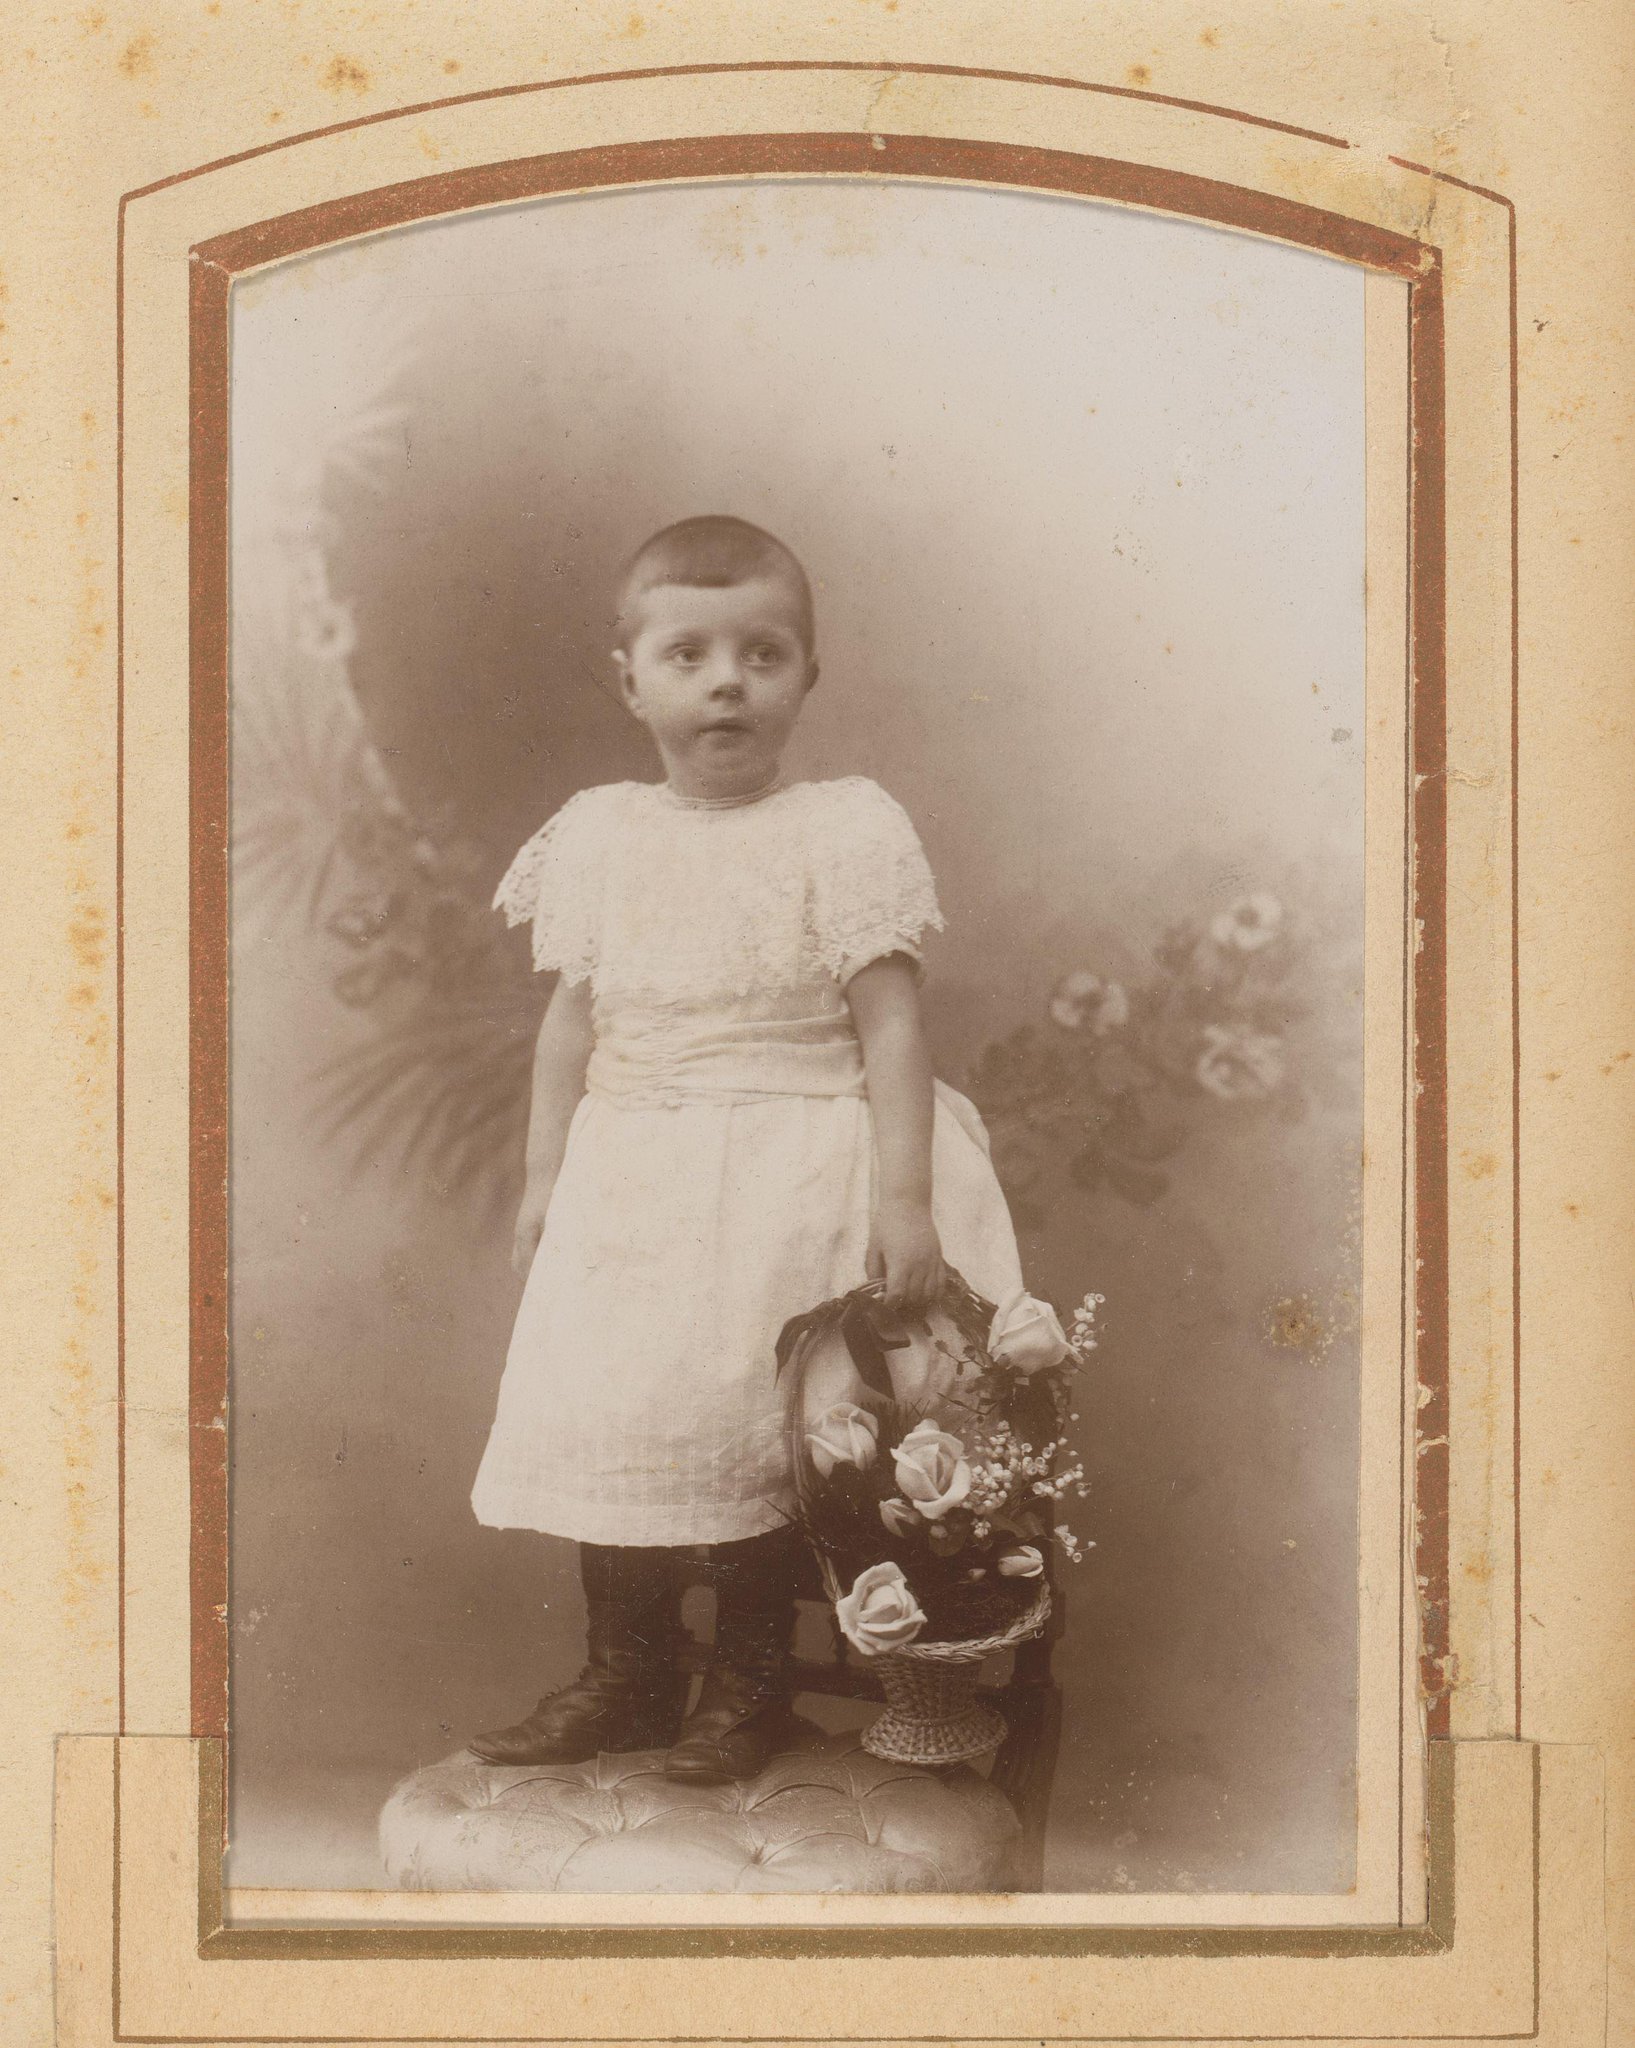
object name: cabinet photograph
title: Portret van een kind, staand op een stoel met bloemen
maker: cornelis johannes lodewicus vermeulen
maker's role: fotograaf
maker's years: 1861-1936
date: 1880-1910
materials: cardboard, photographic support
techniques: collodion silver print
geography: amsterdam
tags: cut flowers; nosegay, bunch of flowers, child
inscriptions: inscription: ‘Photographische/ Ateliers/ C.J.L. Vermeulen/ Heerenstraat 6/ & Heiligenweg hoek Singel/ Amsterdam’